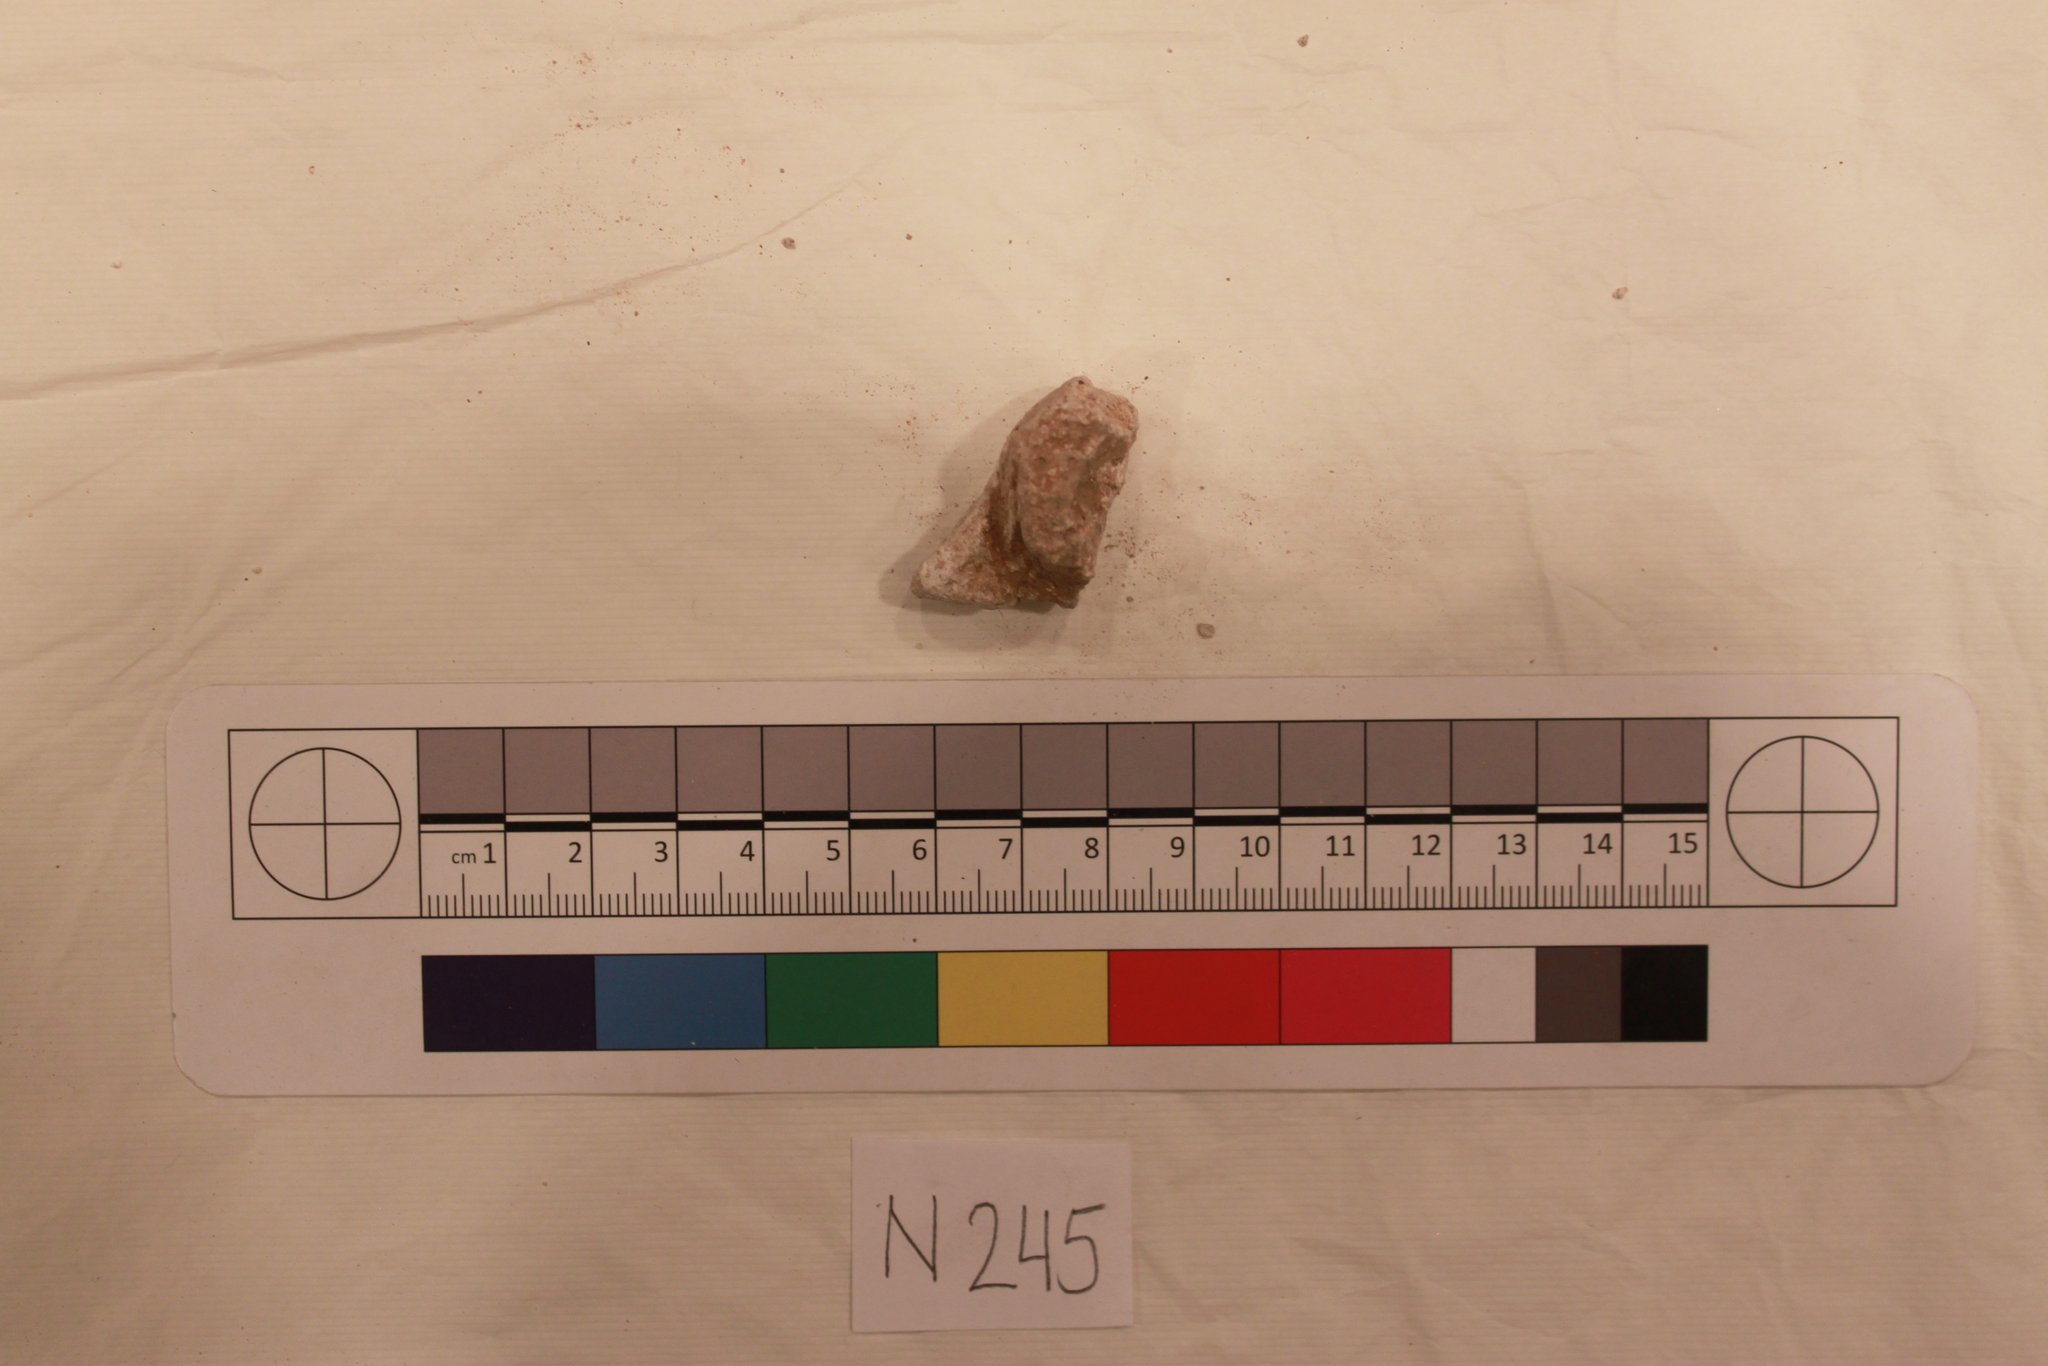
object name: fragment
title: Stucco Fragment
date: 701-1200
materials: plaster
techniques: carving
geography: iran